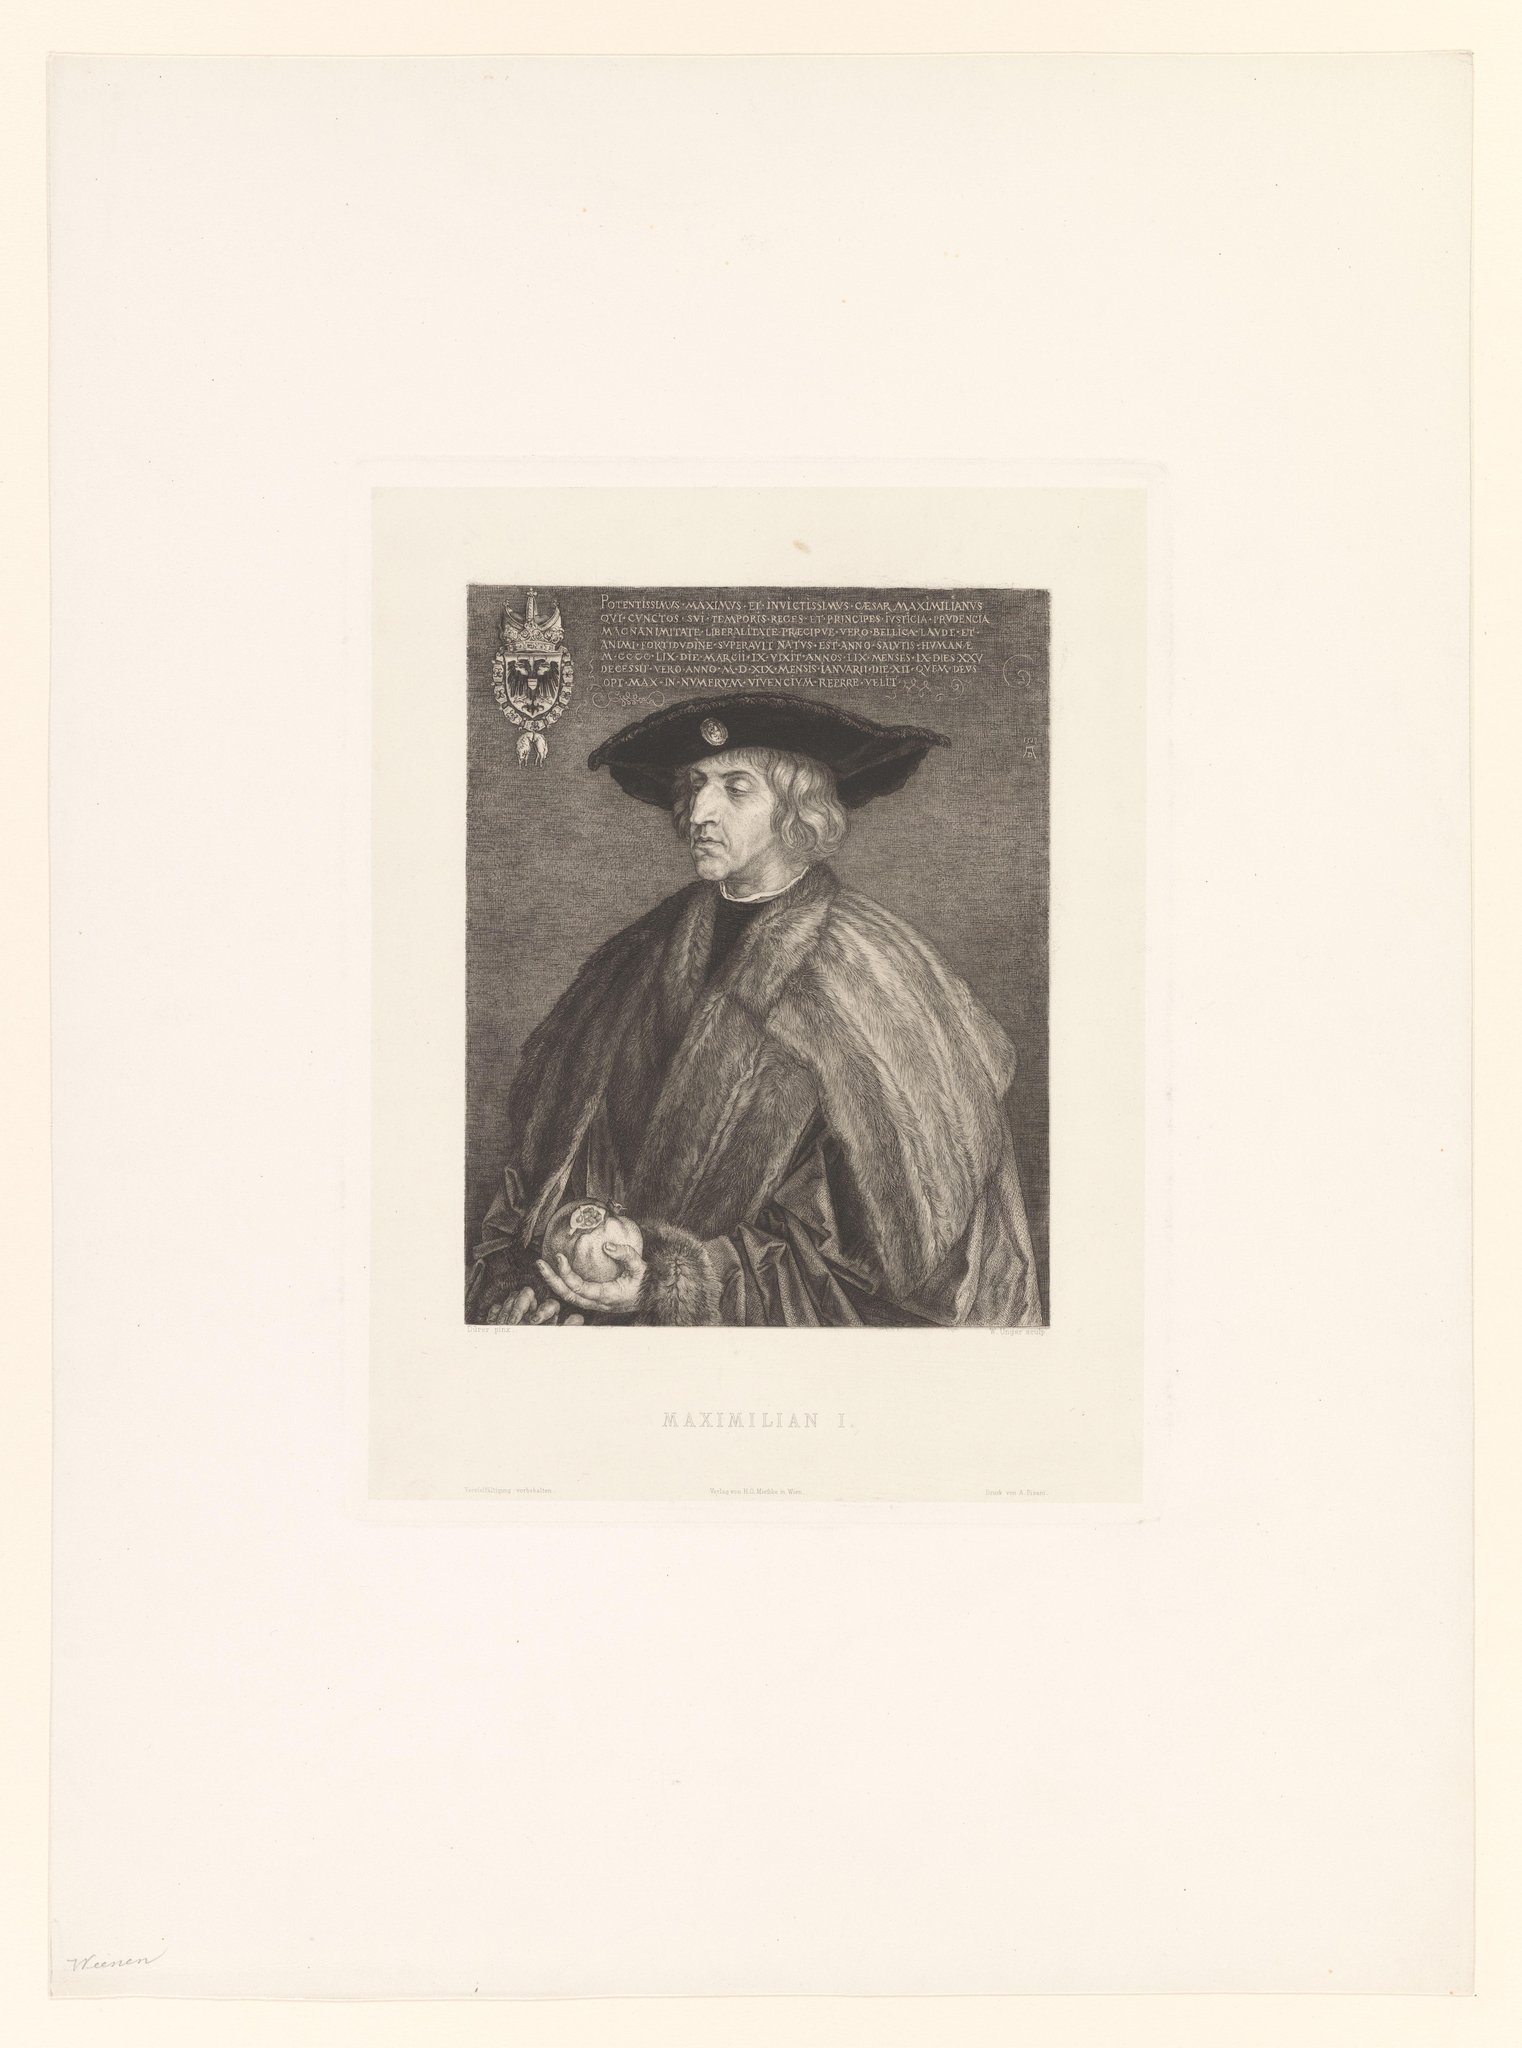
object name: print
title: Maximiliaan I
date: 1861-1889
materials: paper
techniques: etching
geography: vienna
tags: maximilian i (holy roman emperor), fruits: pomegranate, historical persons, armorial bearing, heraldry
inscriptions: collector's mark: Lugt 2228